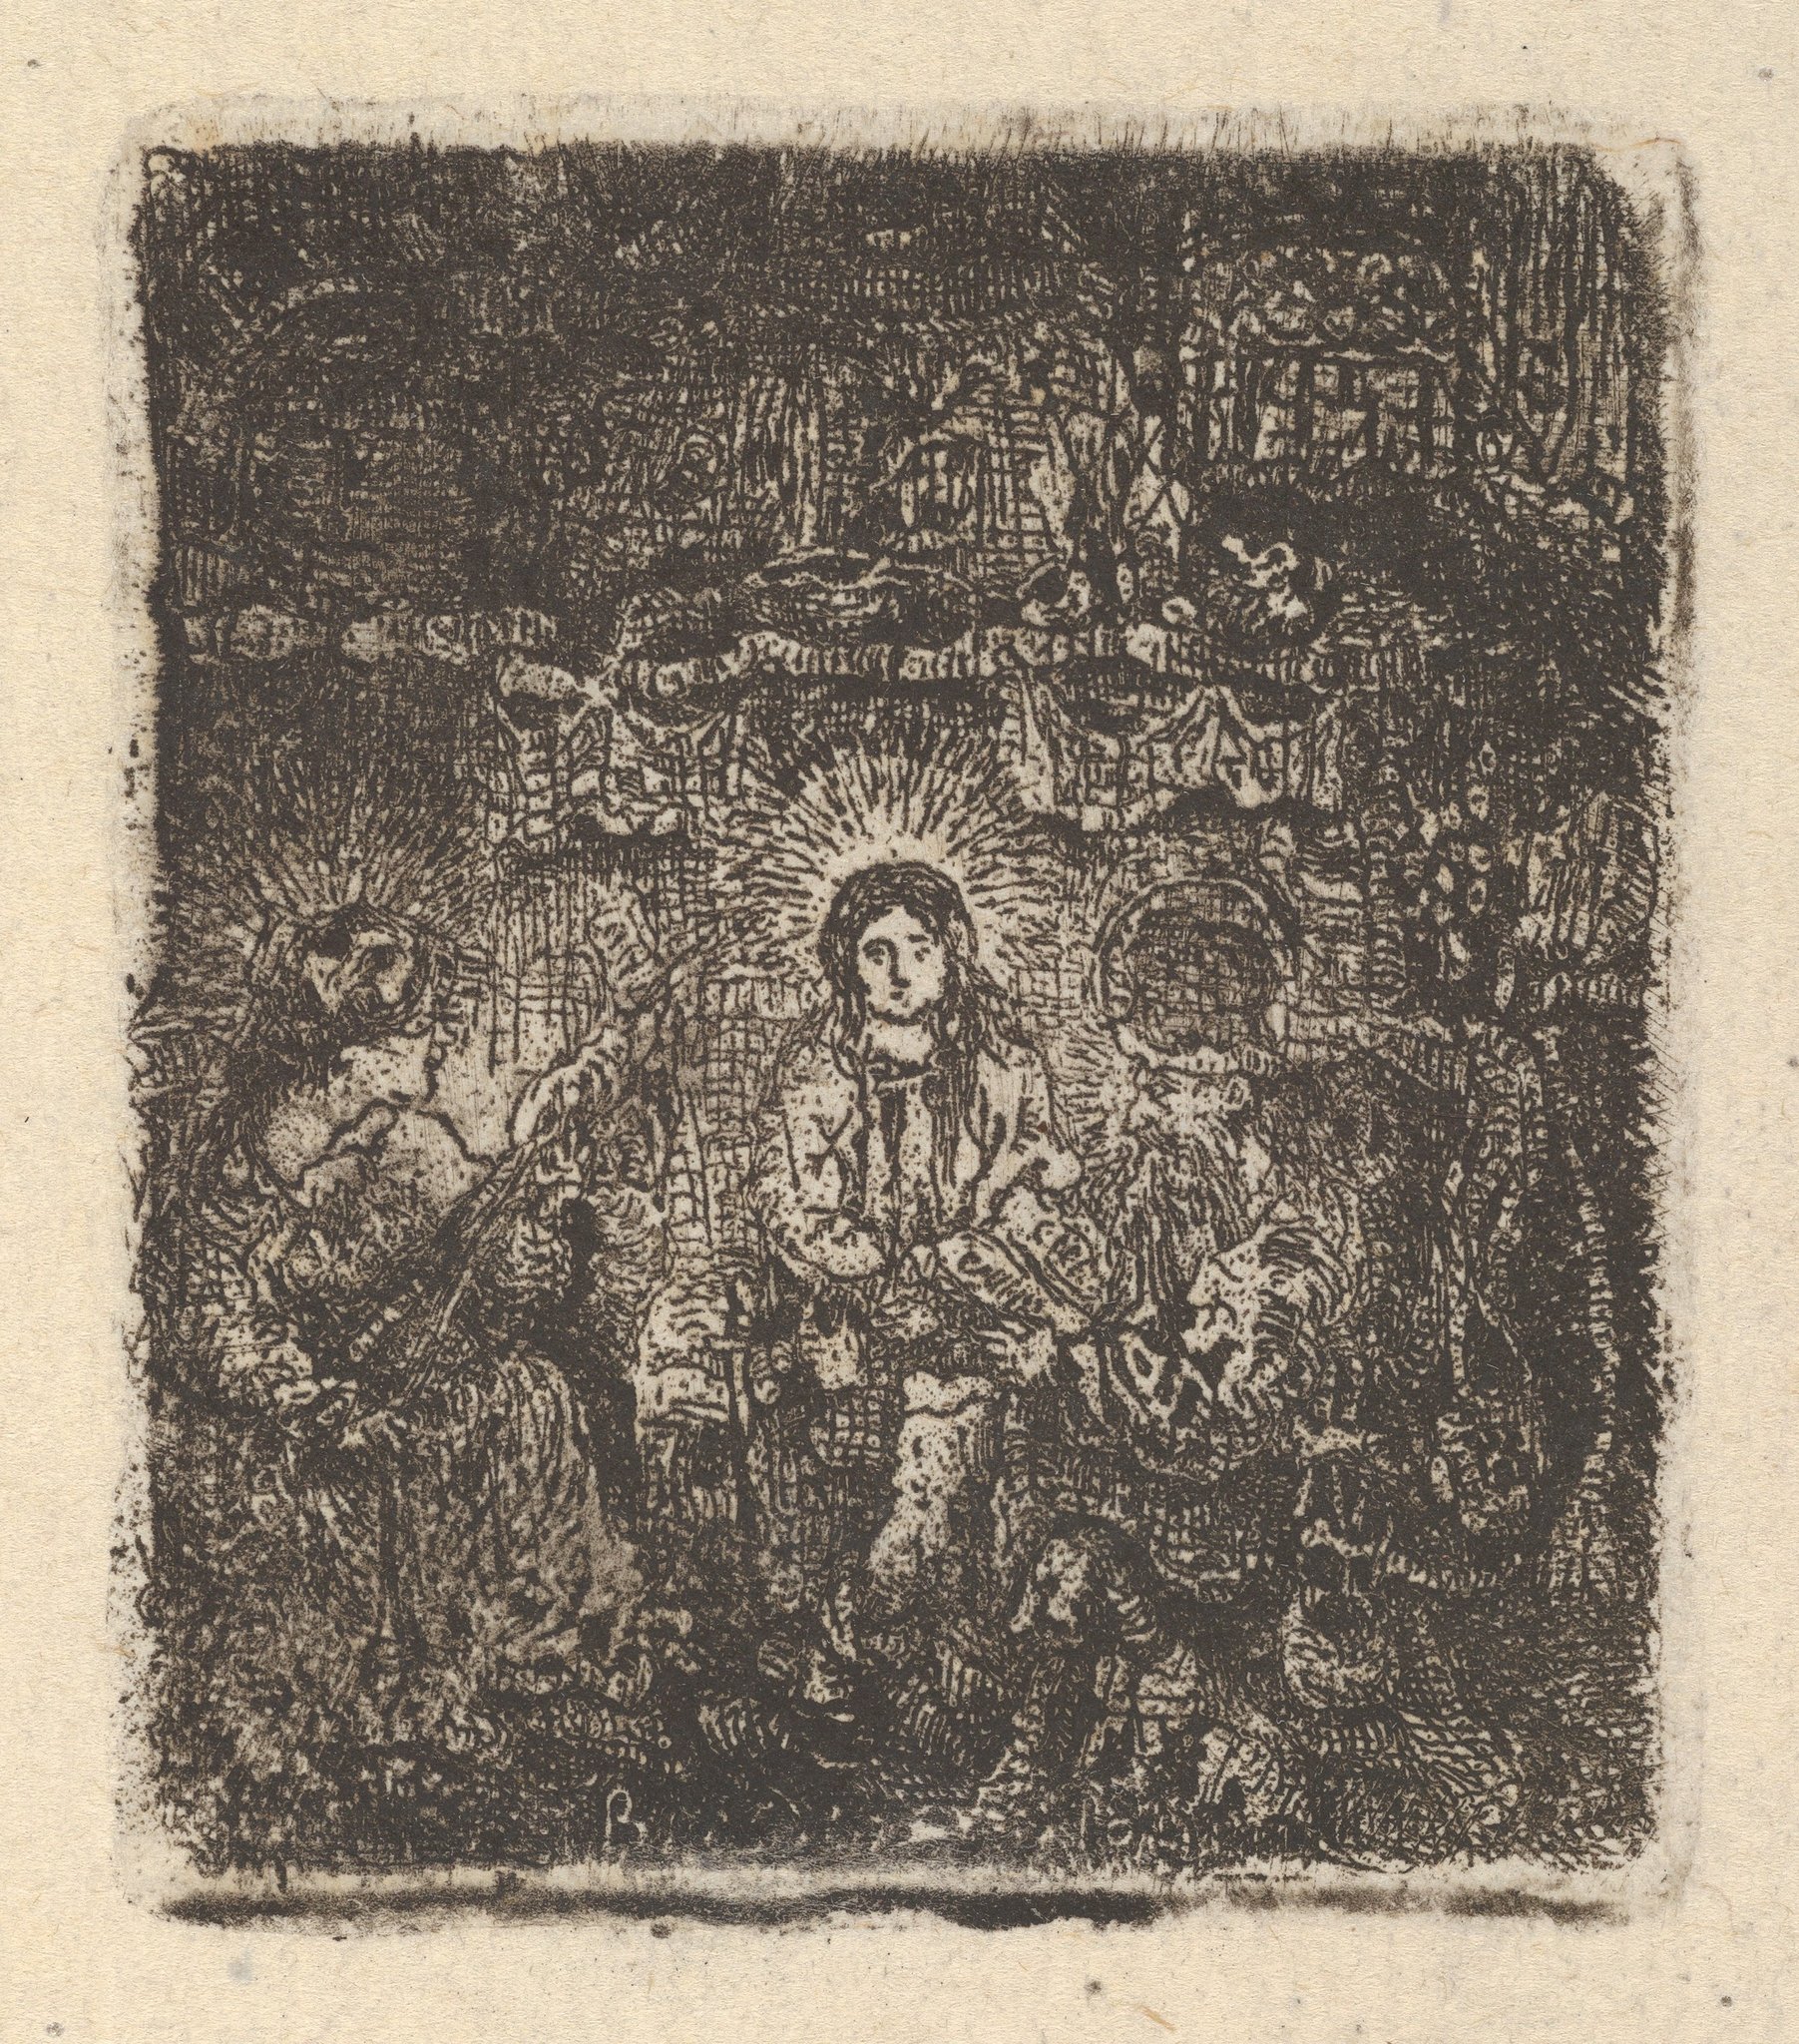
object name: print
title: La Sainte Famille (The Holy Family)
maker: rodolphe bresdin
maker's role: artist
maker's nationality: french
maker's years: 1822-1885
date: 1801-1900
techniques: etching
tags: holy family